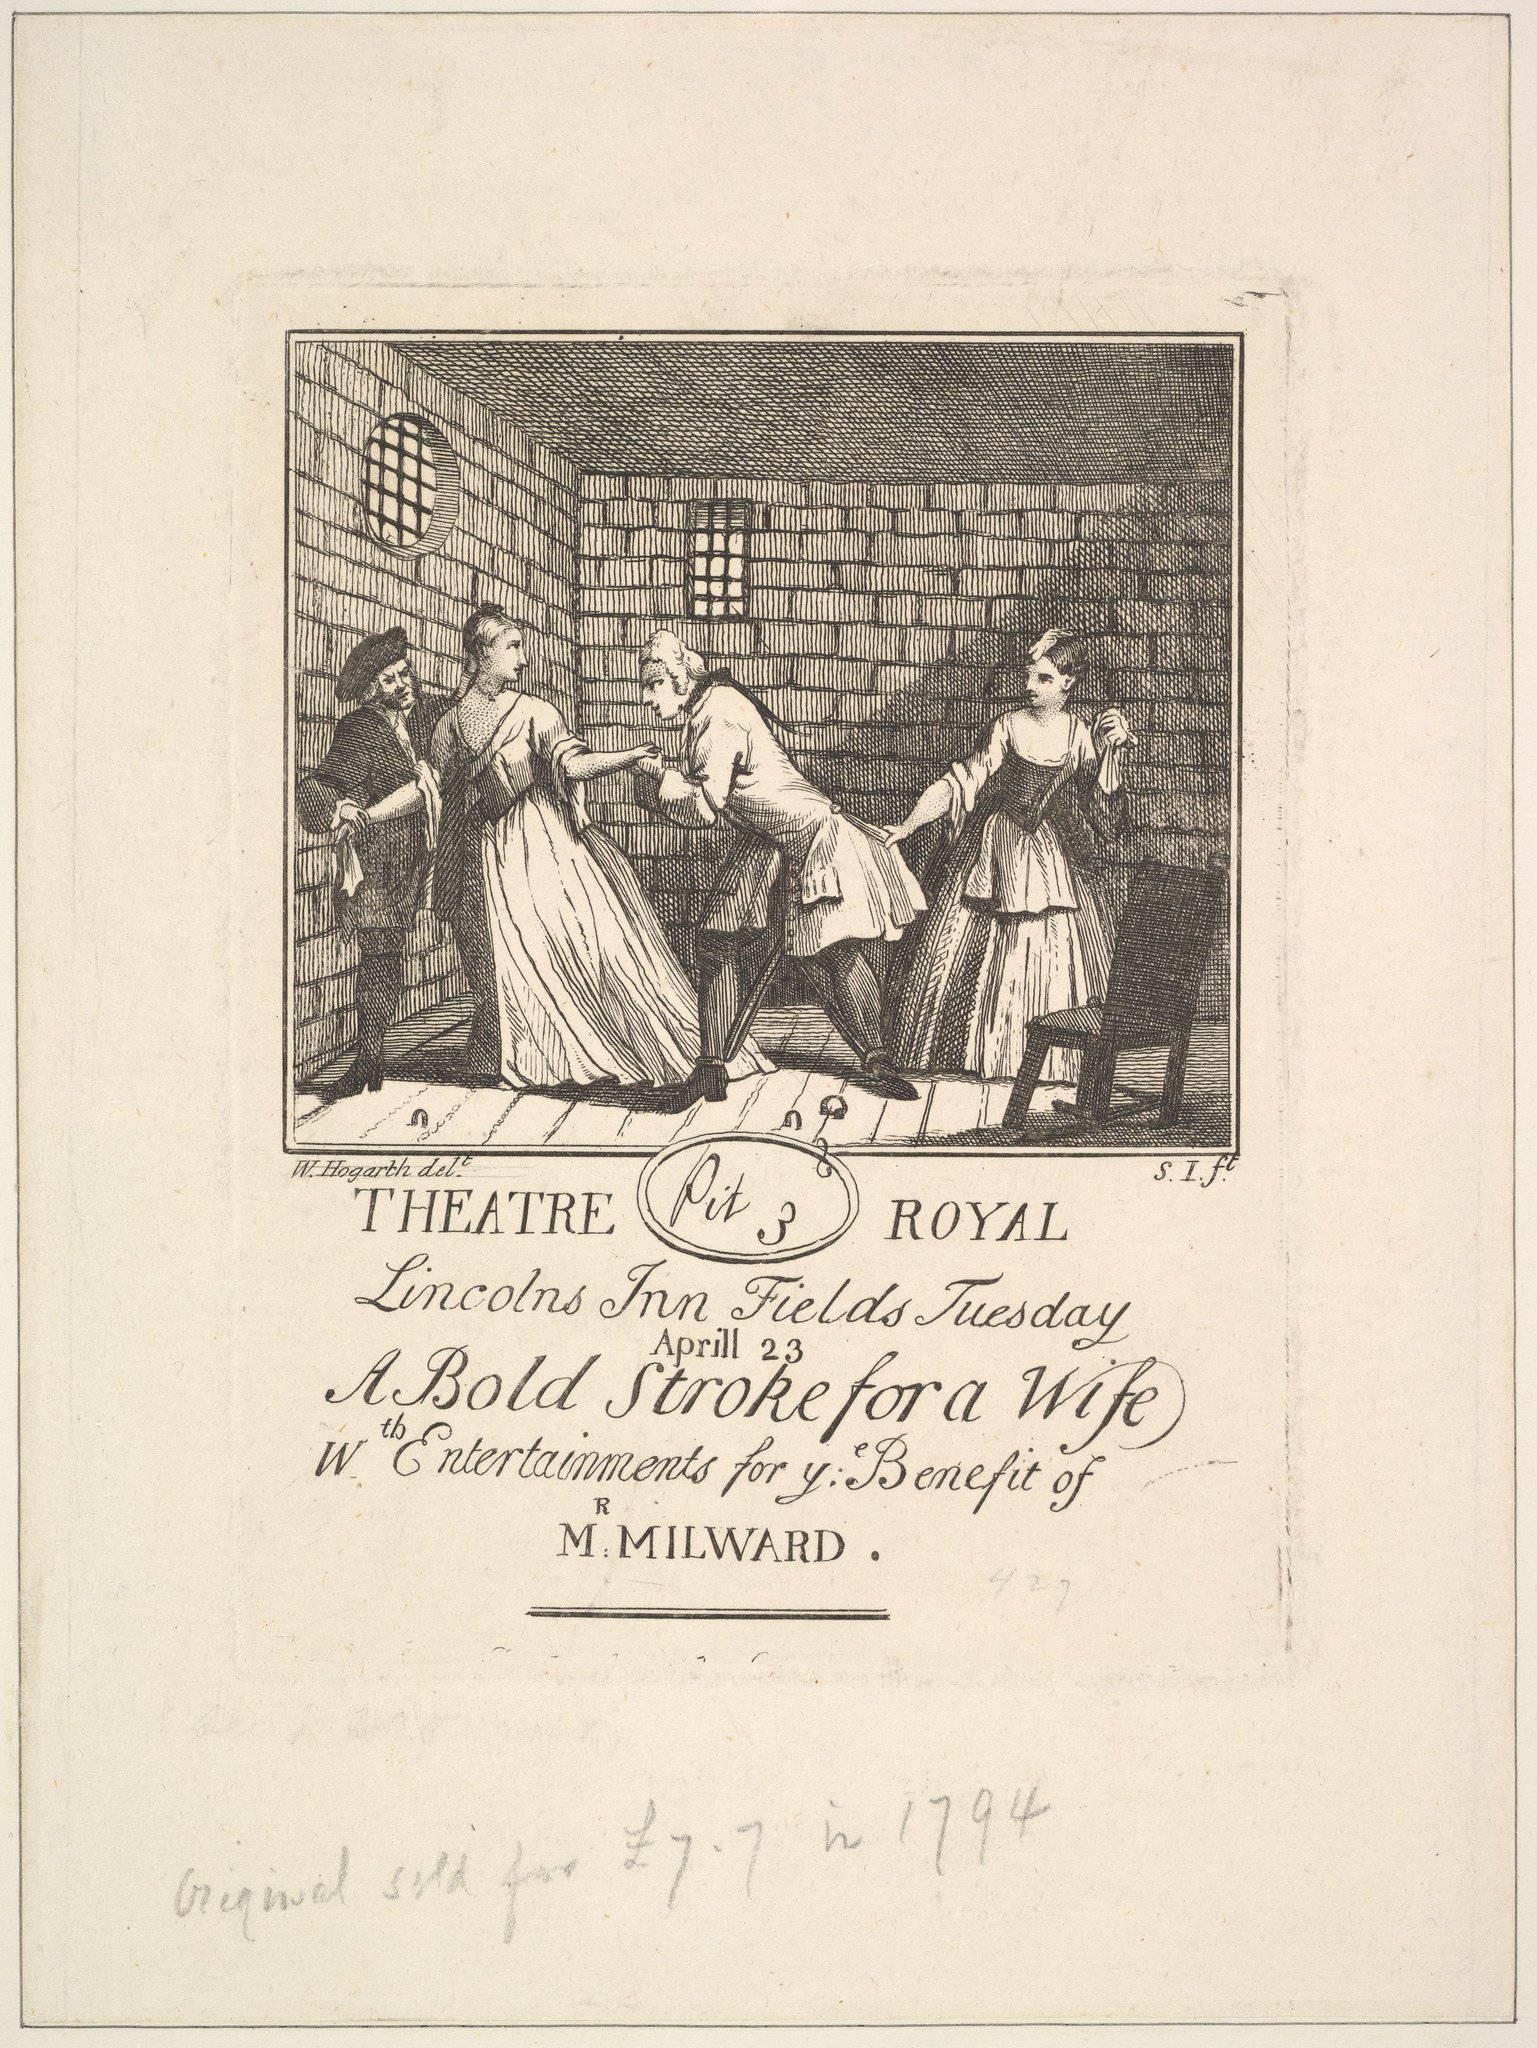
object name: print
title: Benefit Ticket for Milward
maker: samuel ireland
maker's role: etcher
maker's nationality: british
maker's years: 1700-1800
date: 1788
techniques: engraving, etching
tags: men,women